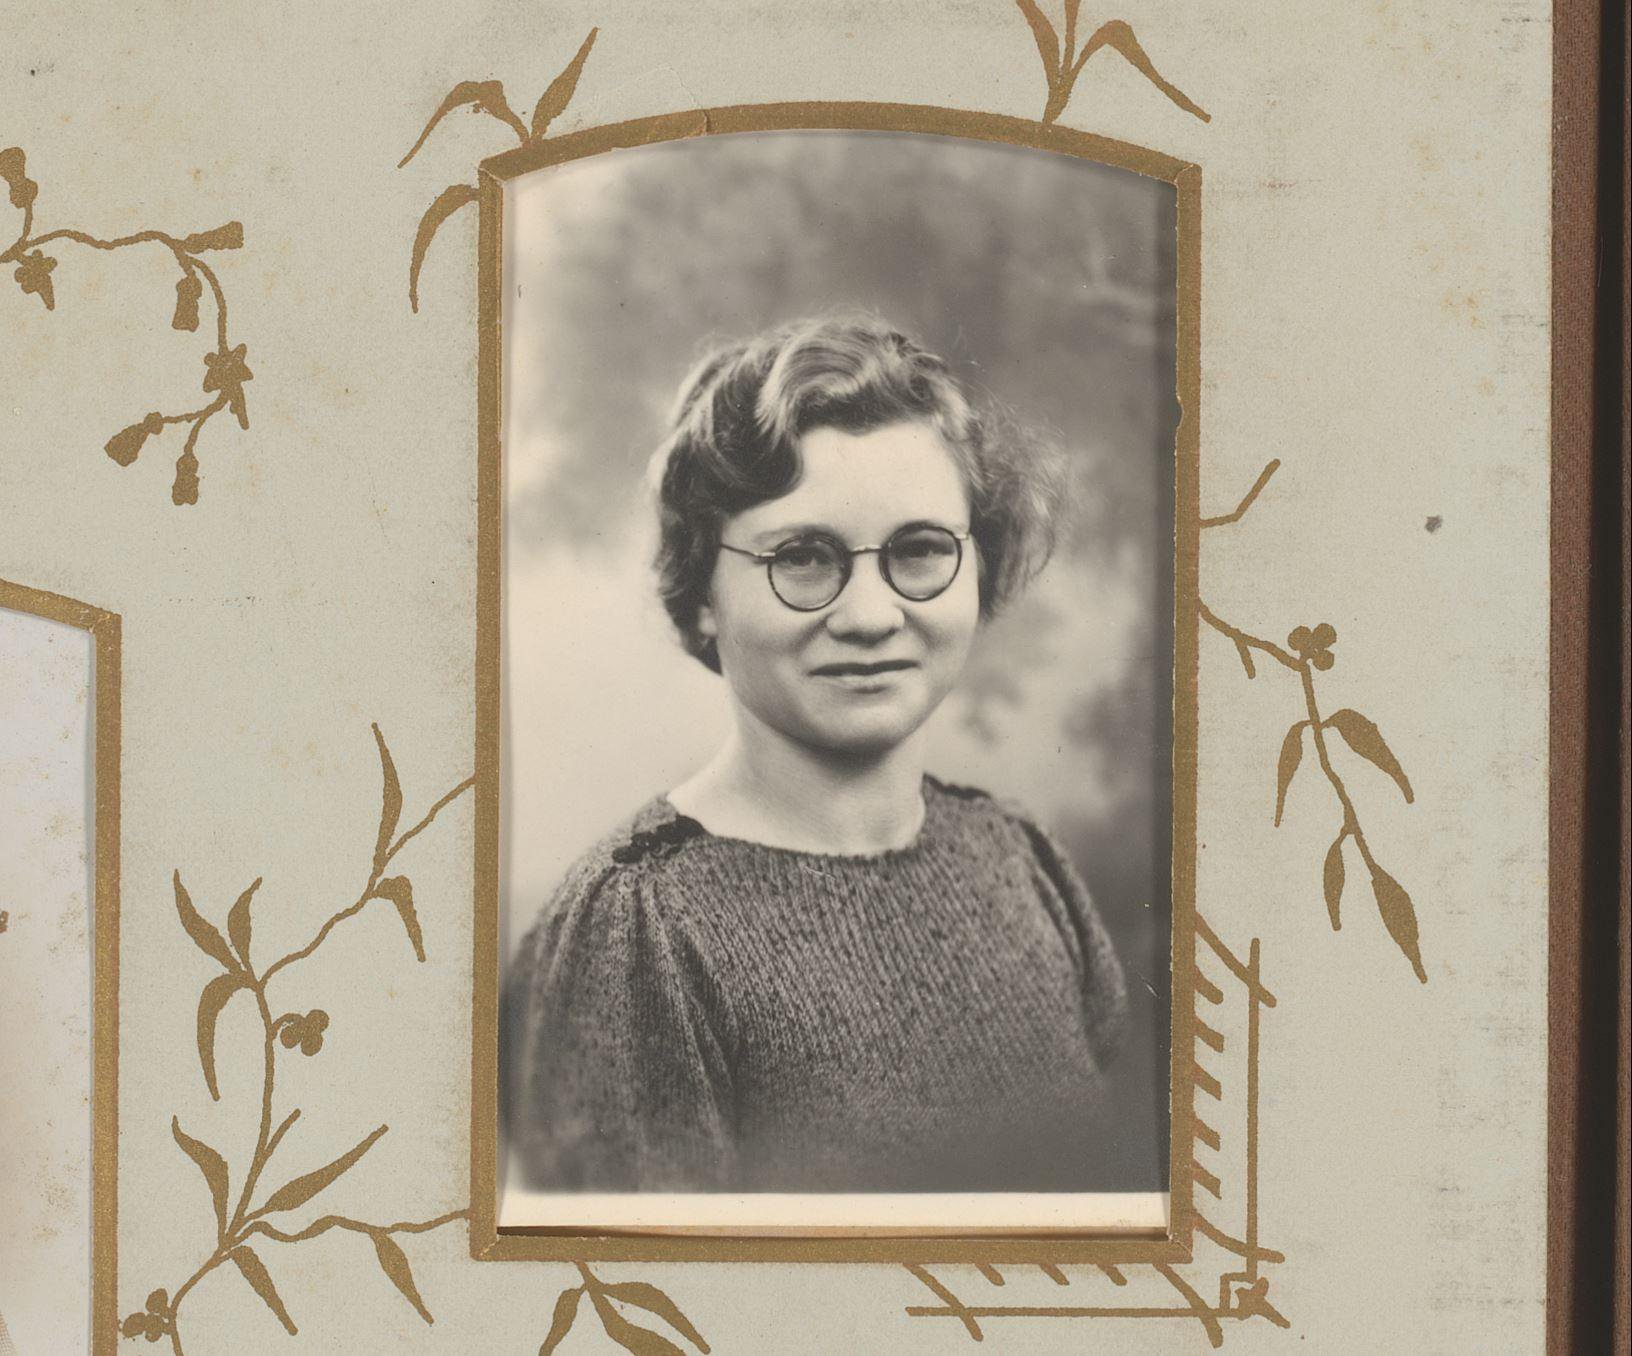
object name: album leaf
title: Portret van een vrouw met bril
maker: Anonymous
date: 1899-1940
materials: cardboard, photographic support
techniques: gelatin silver print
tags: eyeglasses, spectacles, adult woman, historical persons